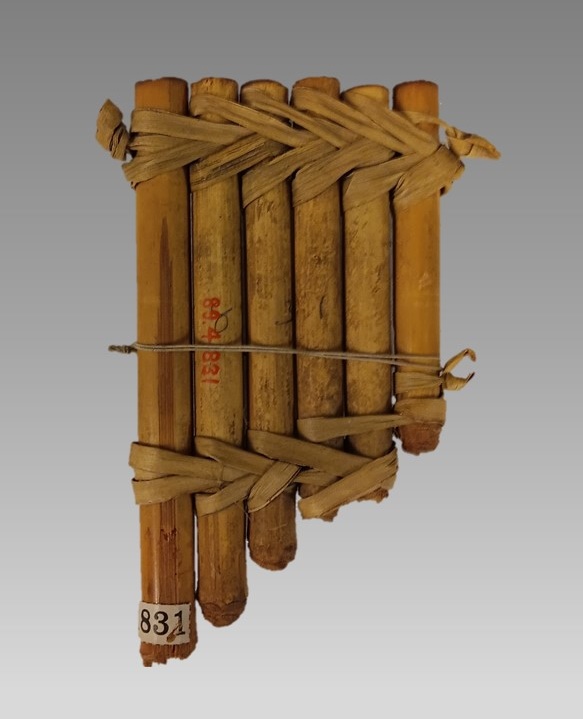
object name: pachava panpipe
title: Pachava (panpipes)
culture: melanesian, pentecost island or vanuatu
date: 1867-1900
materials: bamboo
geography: vanuatu